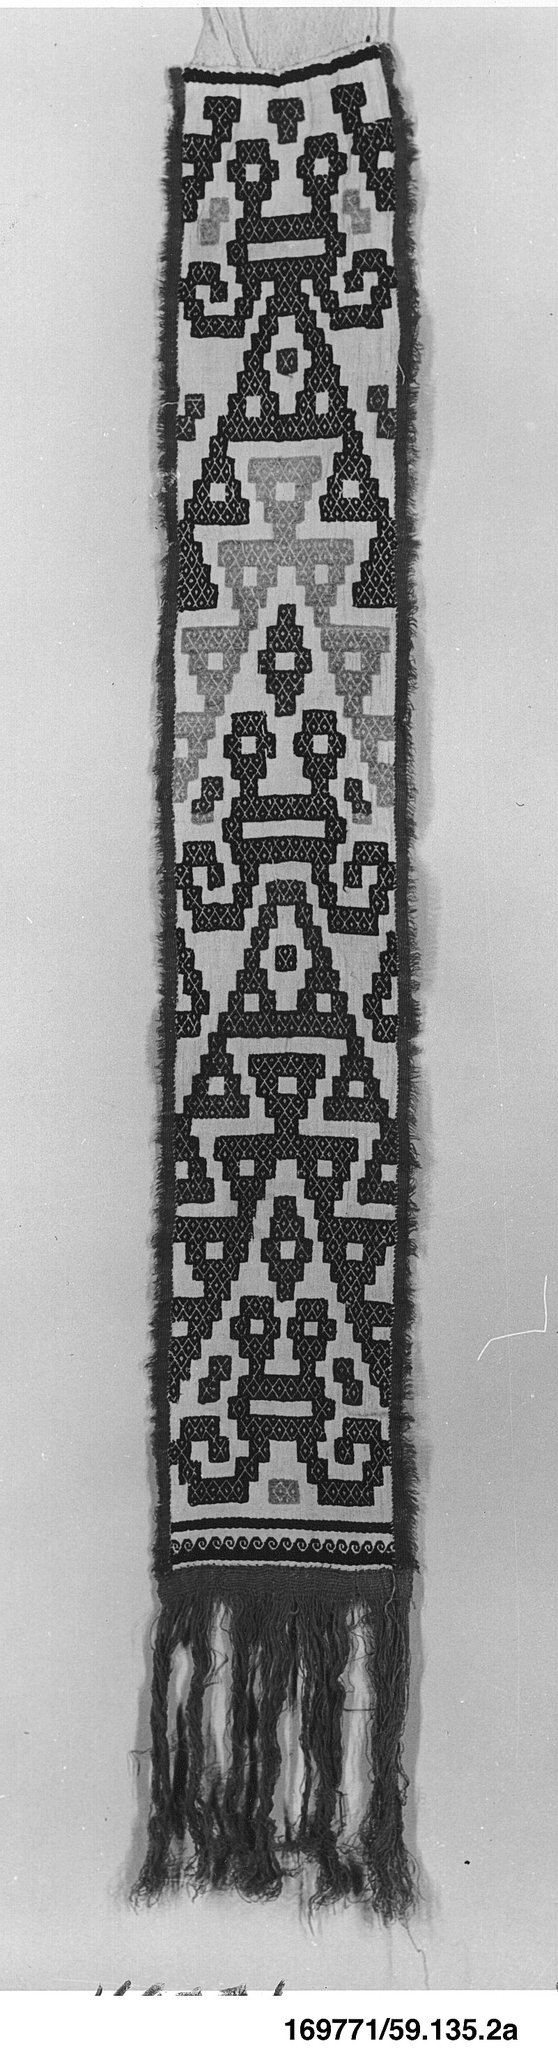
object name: headband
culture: chimú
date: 1101-1500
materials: animal fiber, cotton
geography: peru